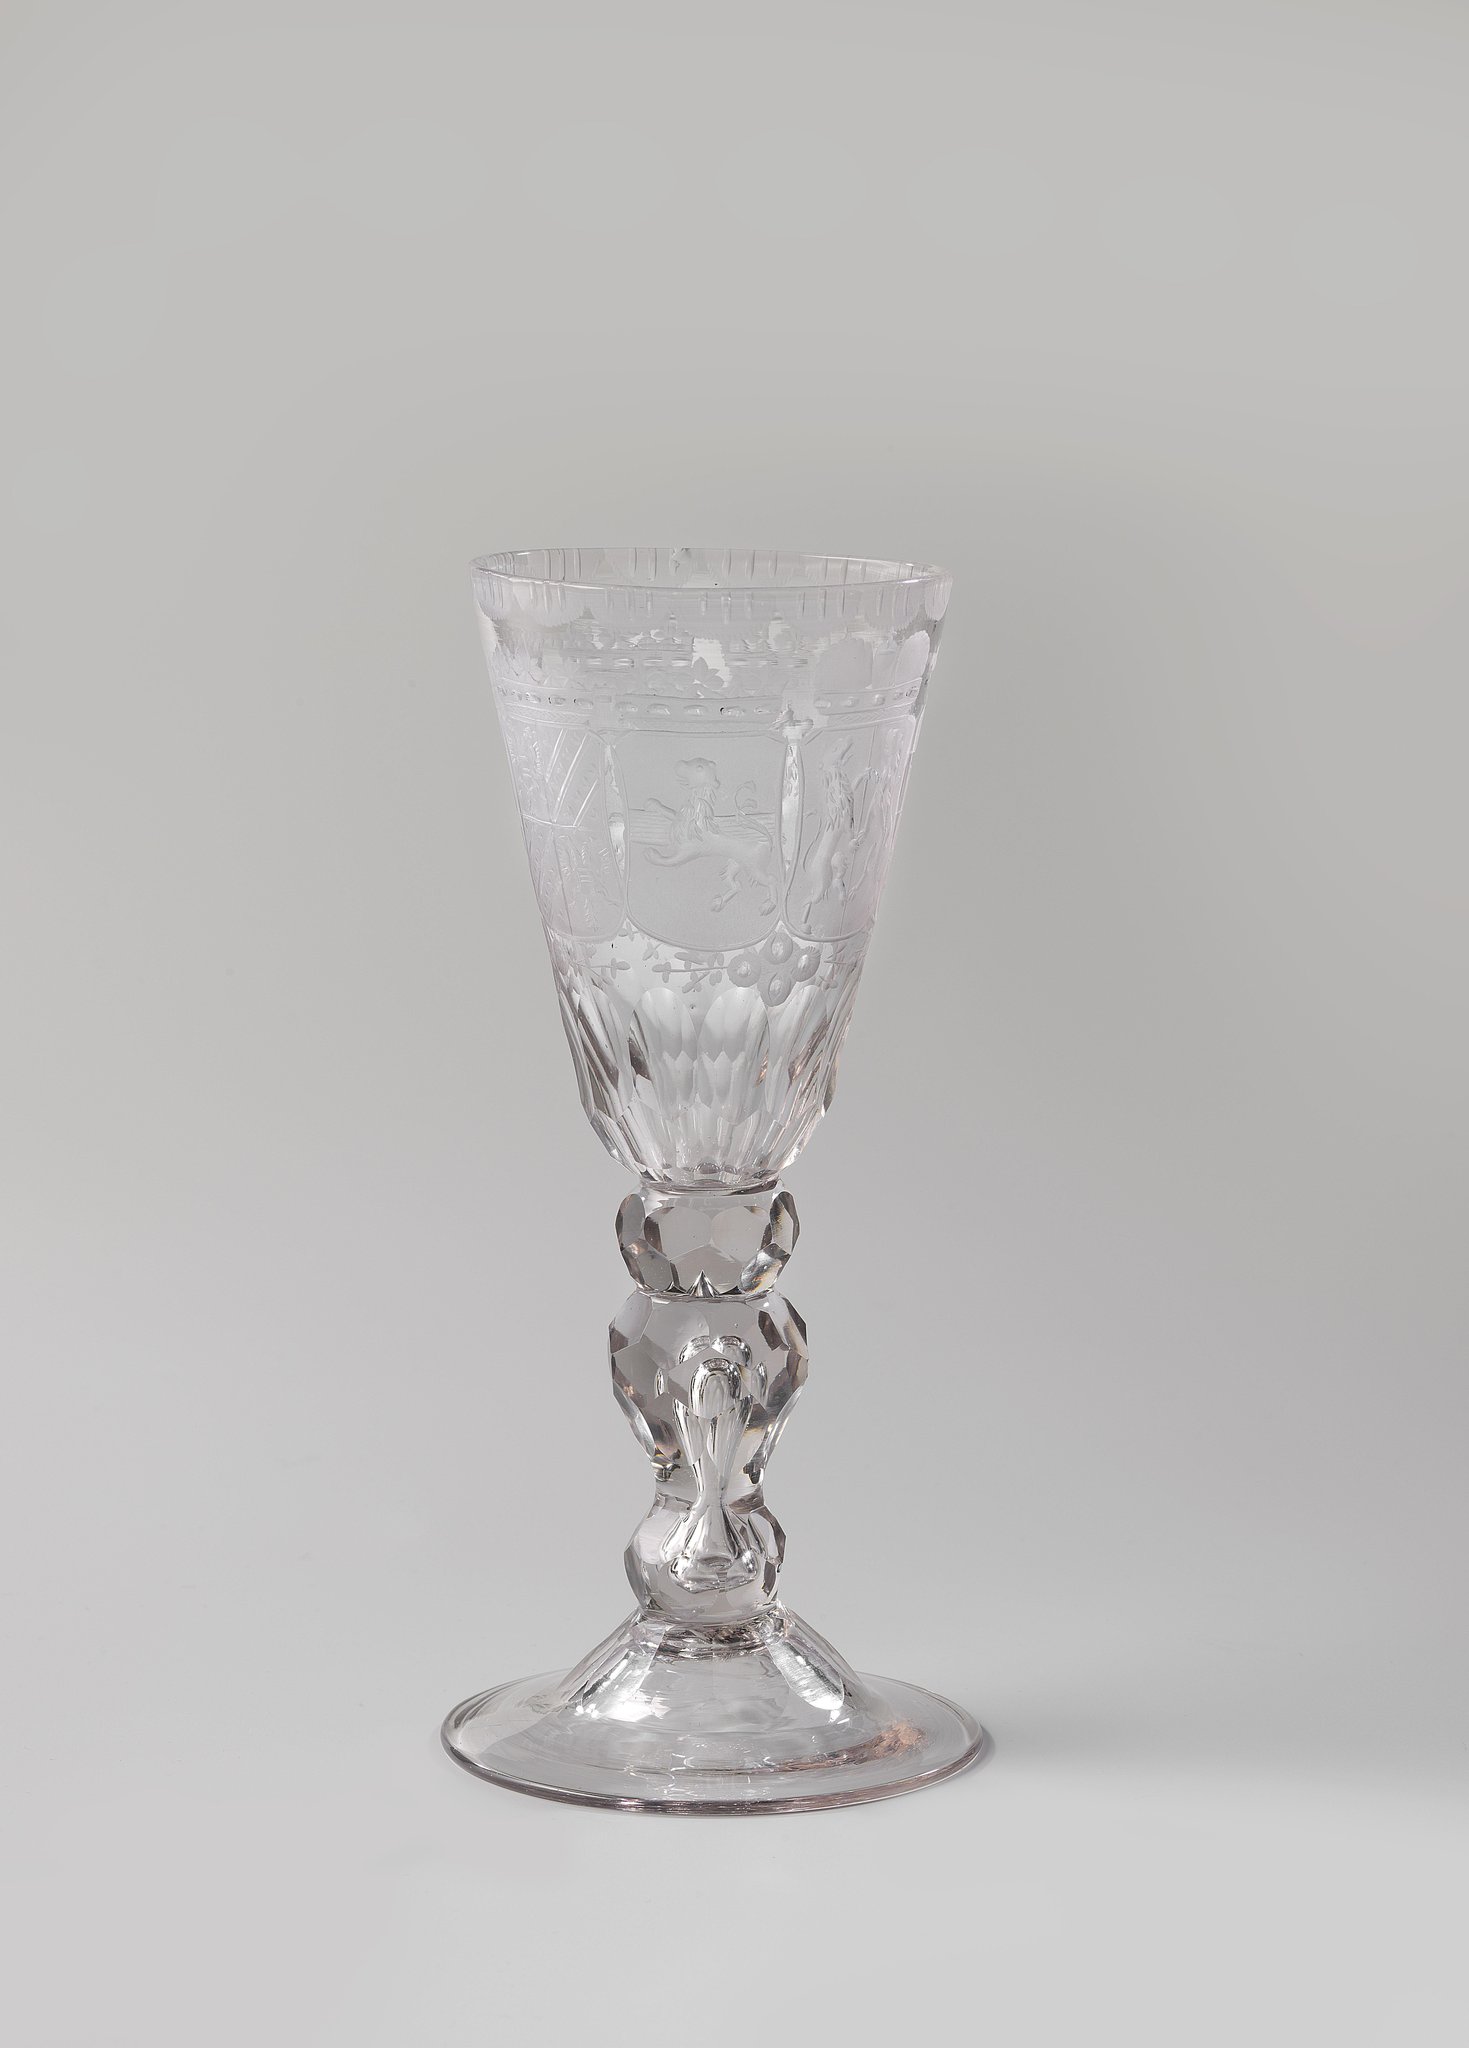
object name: lid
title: Bokaal met deksel, met de wapens van de Zeven Verenigde Provinciën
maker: Anonymous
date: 1725-1750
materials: glass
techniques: glassblowing, grinding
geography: bohemia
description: Gewelfde voet met omgeslagen rand. Balusterstam met geslepen facetten en langgerekte luchtbel. Conische kelk met facetten en voorts versierd, met de wapens der zeven geunieerde gewesten. Het deksel versierd met ornamentwerk.